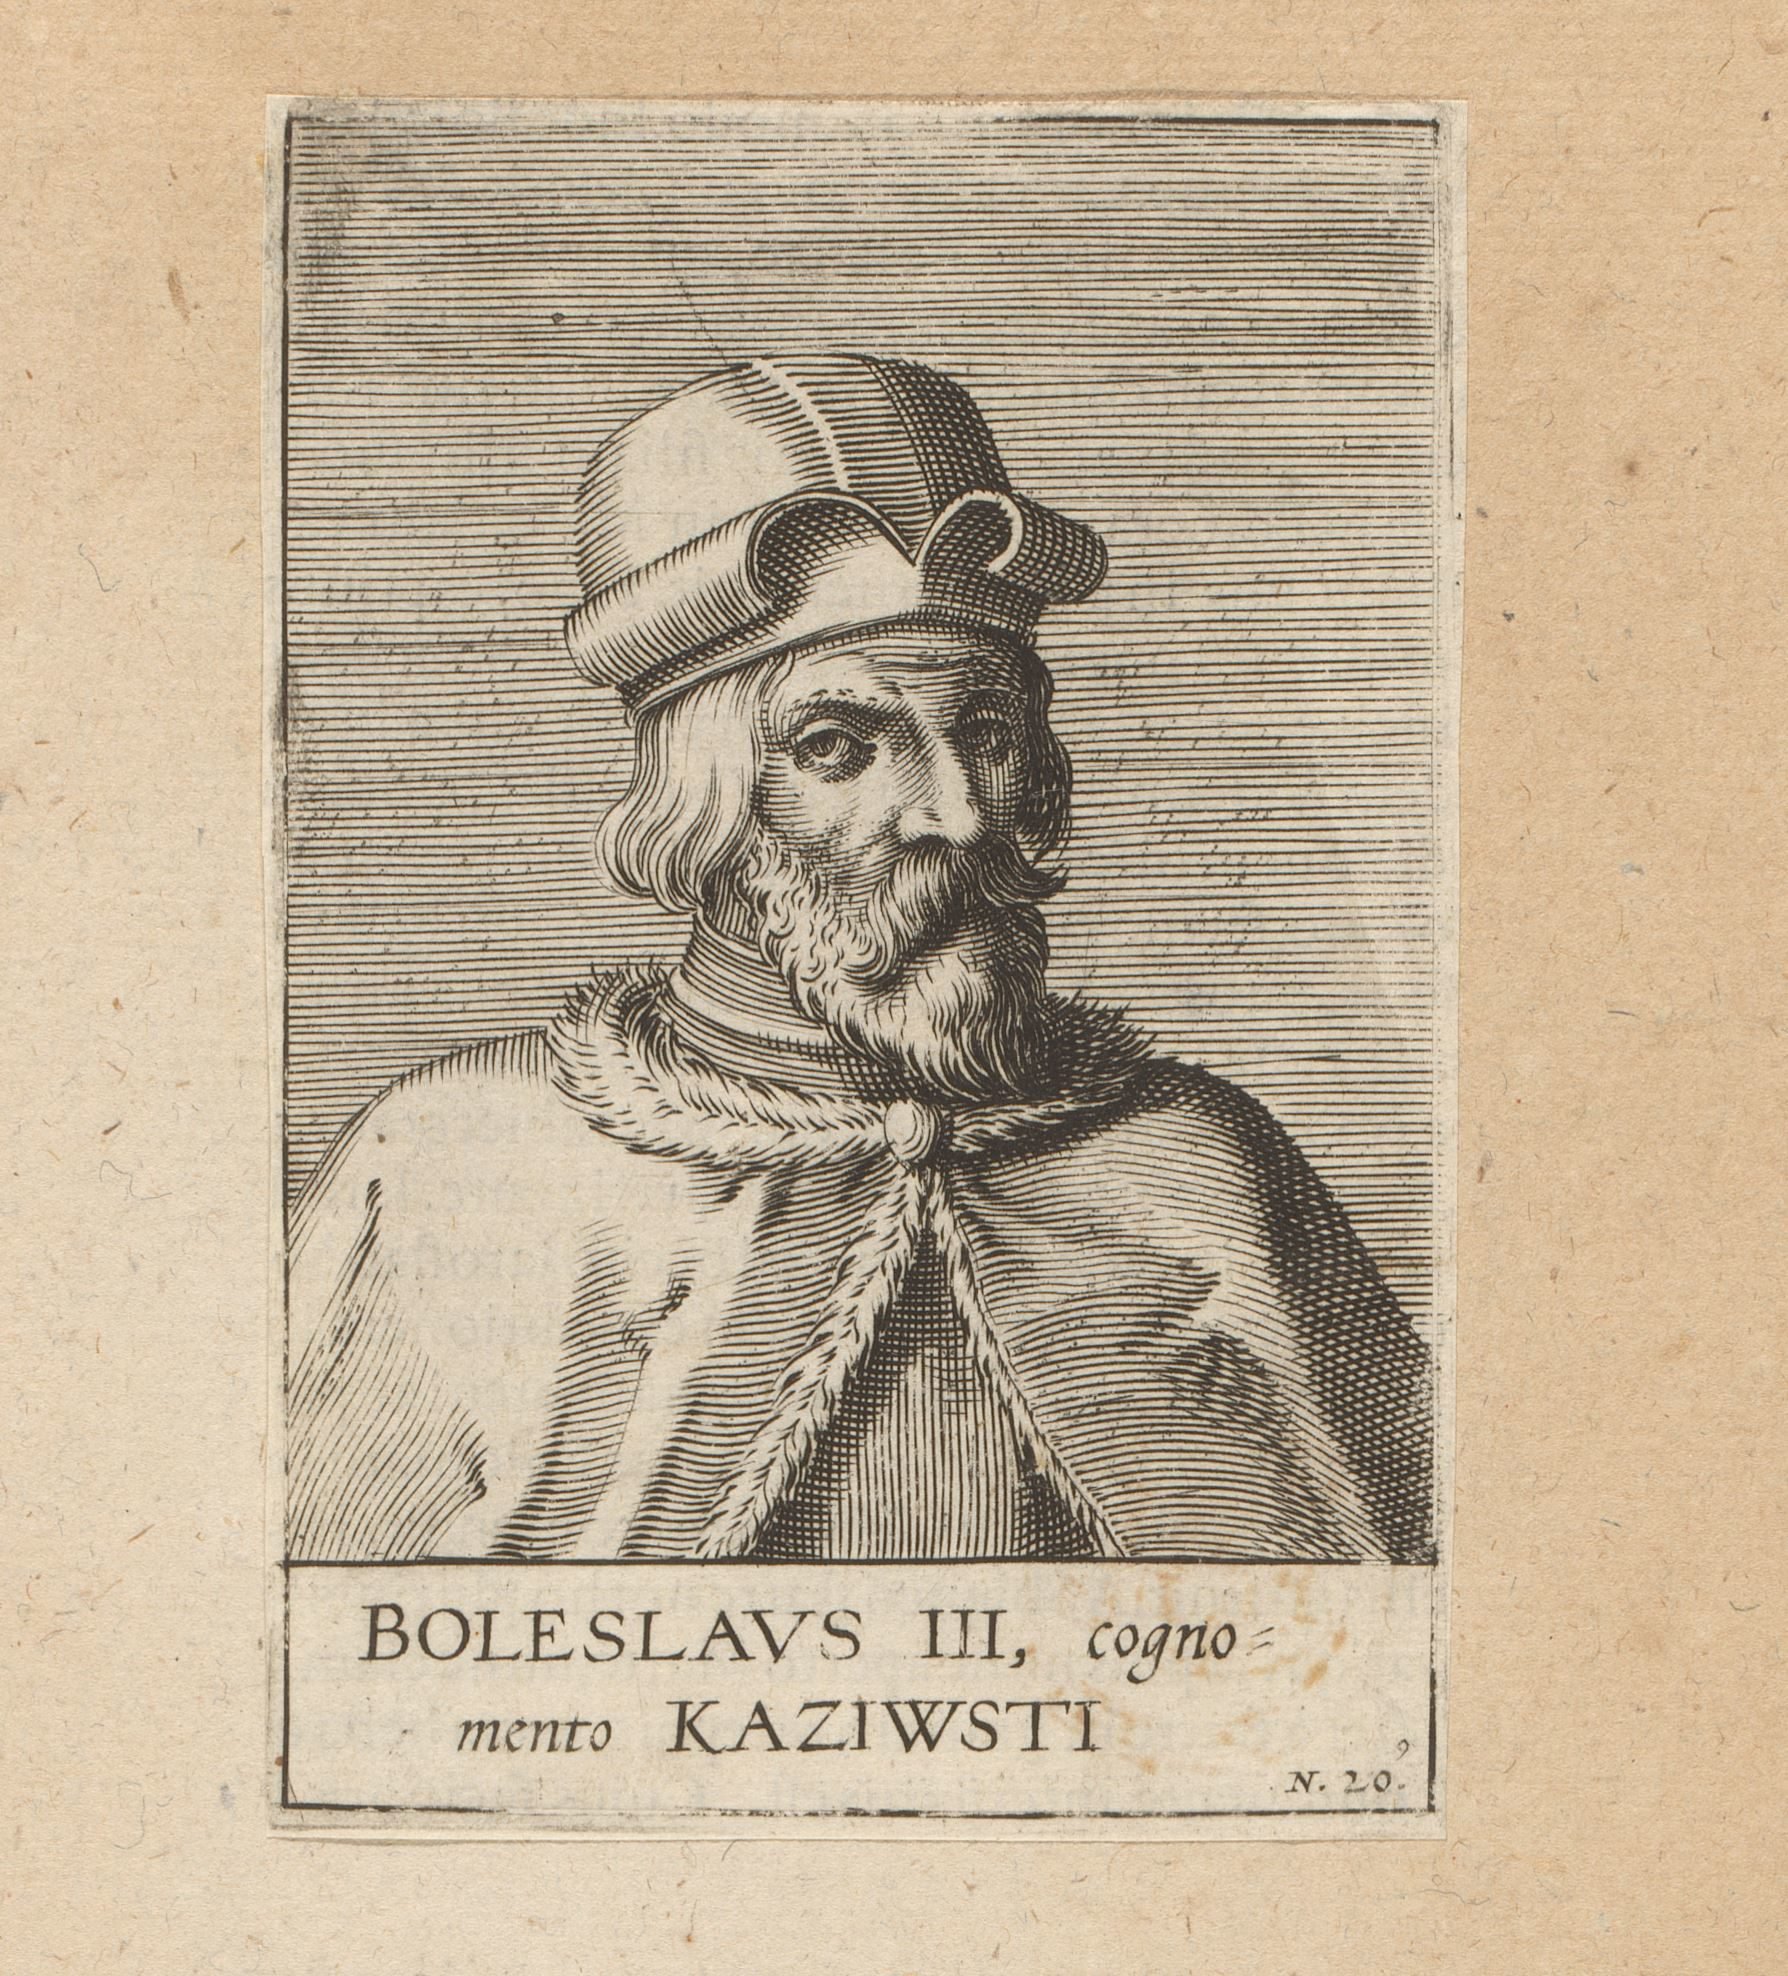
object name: print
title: Portret van Boleslaw III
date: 1574-1594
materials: paper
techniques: woodcut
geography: cologne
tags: poland, historical persons, ruler, sovereign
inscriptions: collector's mark: Lugt 240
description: Prent gebruikt in: Mylius, Arnold. Principum et Regum Polonorum Imagines ad Vivum Expressae (...). Keulen: Gottfried von Kempen, 1594.